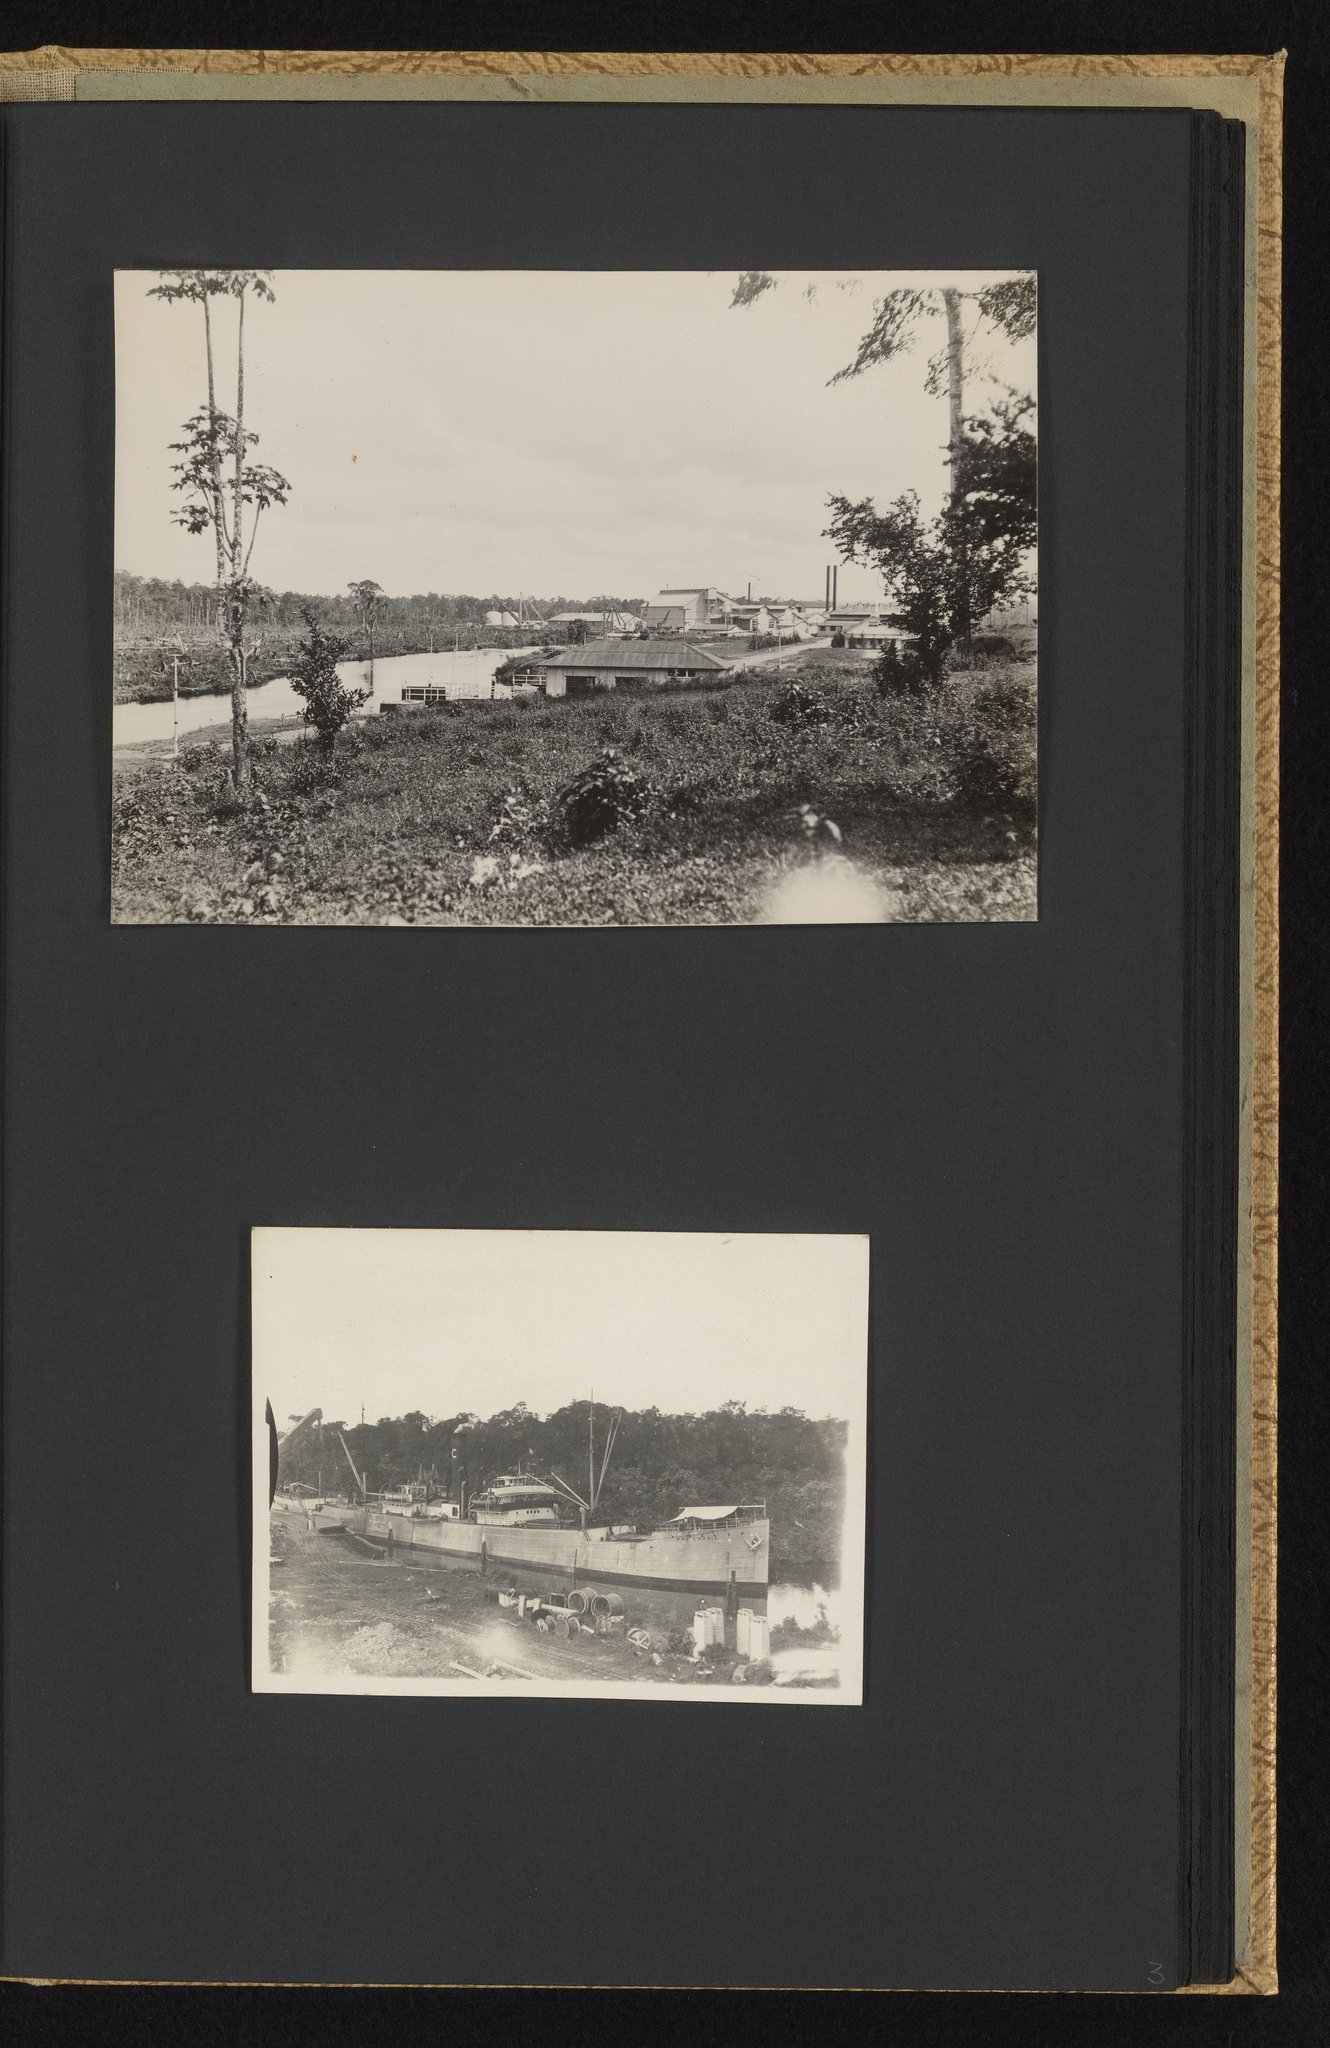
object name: album leaf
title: Fabriek en schip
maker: Anonymous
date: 1929-1930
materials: paper, photographic support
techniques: gelatin silver print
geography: suriname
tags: opencast mine; strip mining, exterior of industrial structures, factories, steamship, motorship, suriname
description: Albumblad met twee foto's: gezicht op het fabriekscomplex en een vrachtschip (Britt-Marie). Onderdeel van het album van de familie Guilonard over de bauxietwinning in Moengo en Albina in Suriname in de jaren 1929-1930.